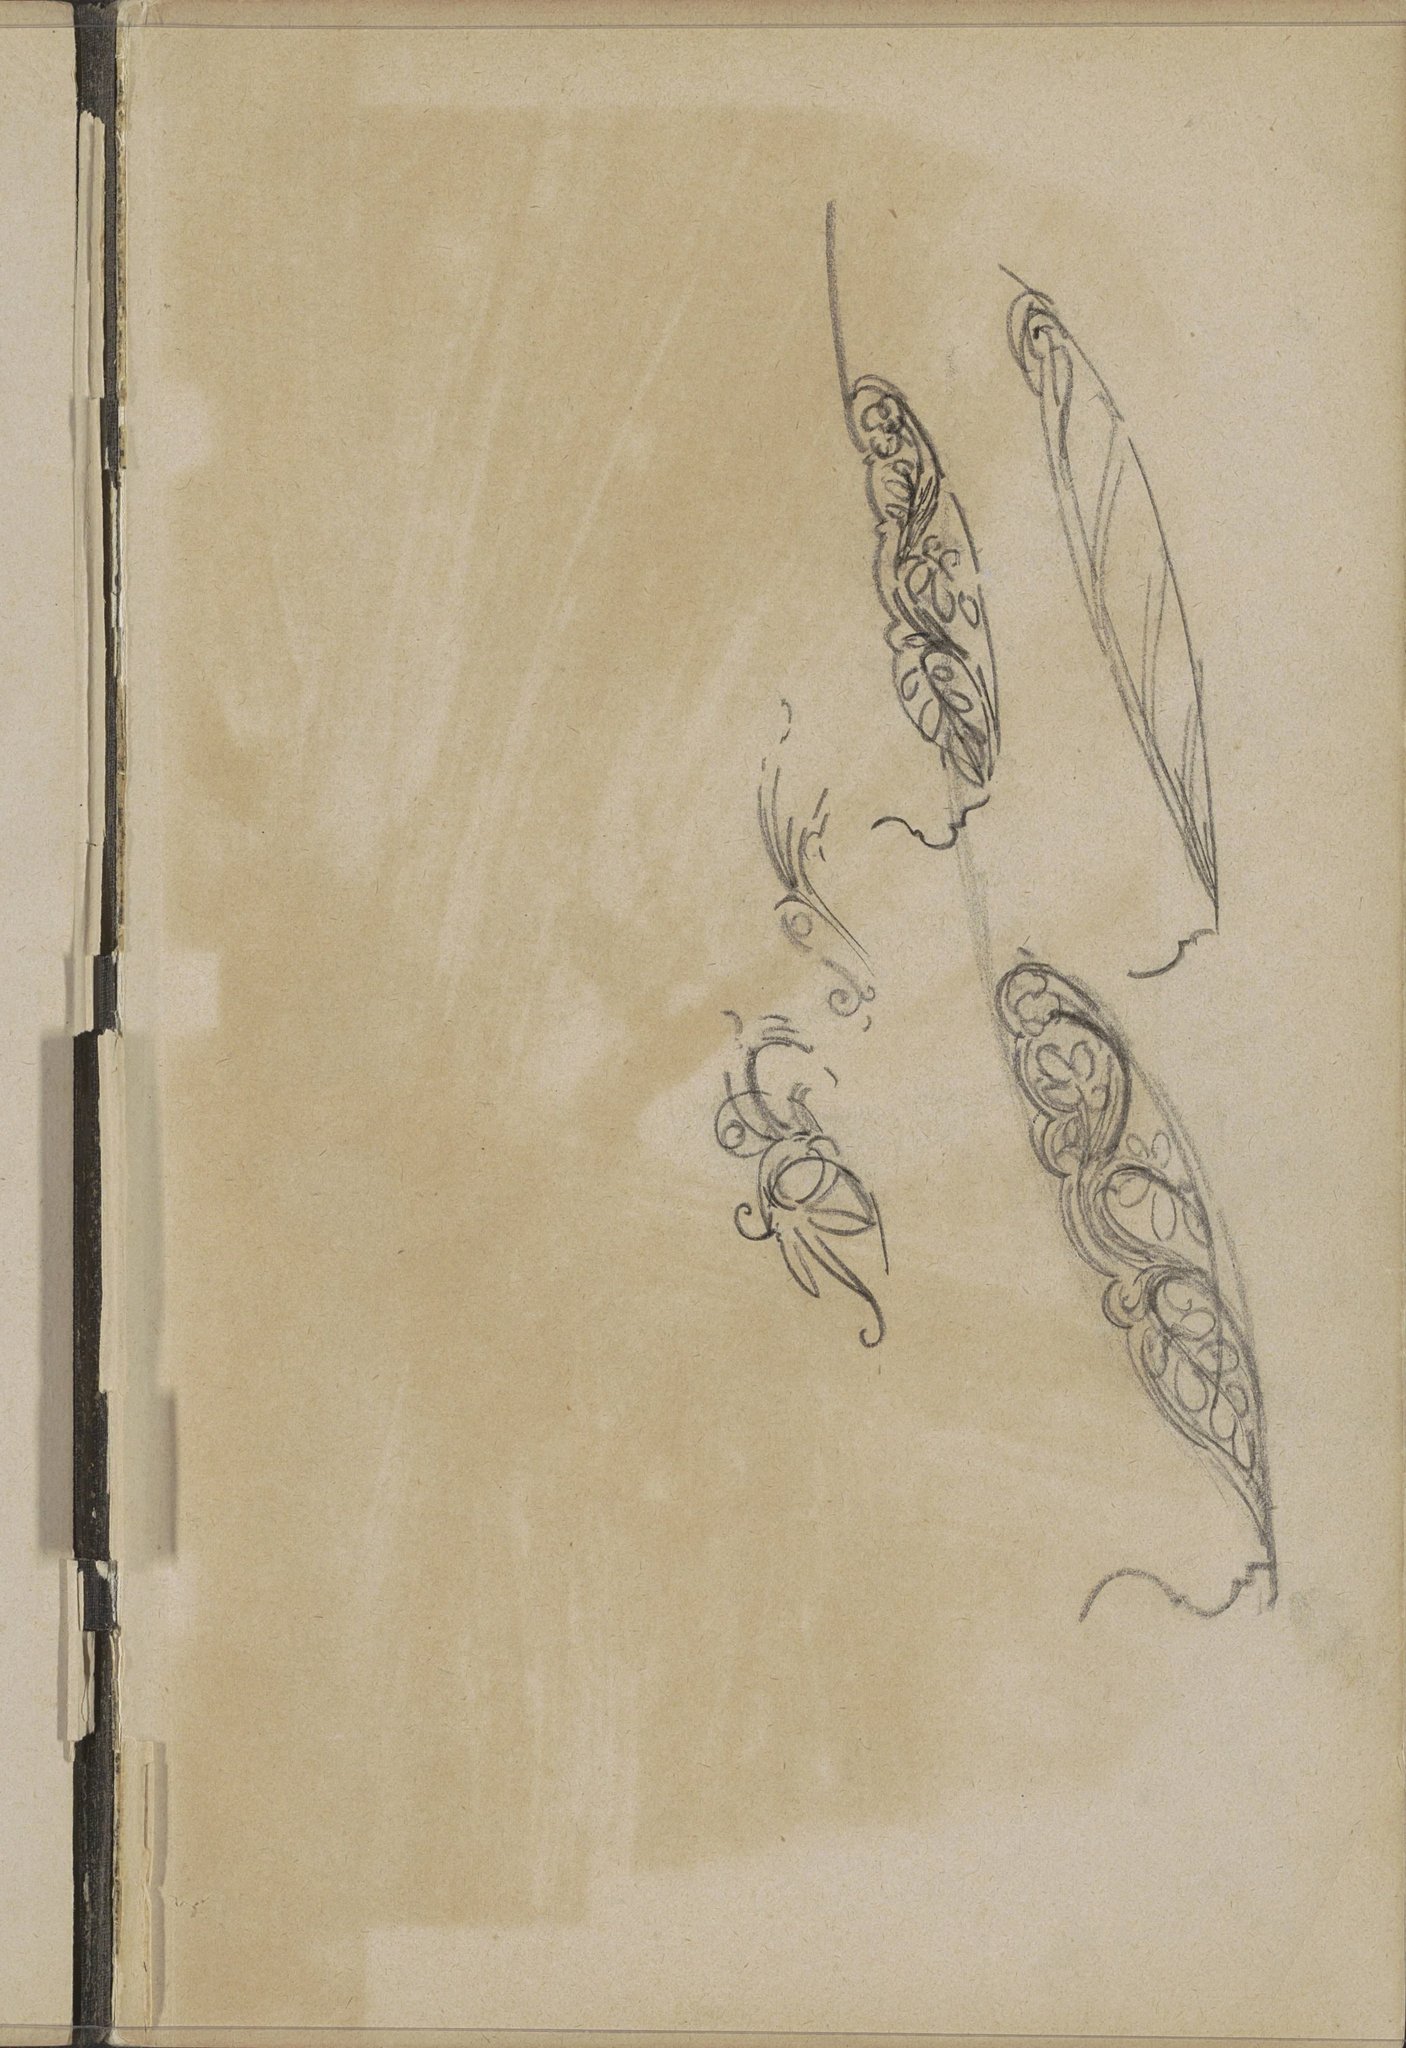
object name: sketchbook leaf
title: Ornamenten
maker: gerrit willem dijsselhof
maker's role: designer, draughtsman, print maker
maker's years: 1866-1924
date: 1901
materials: chalk, paper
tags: flowers ~ ornament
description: Onder andere ornamenten met bloemen. Blad 1 recto uit een schetsboek met 79 bladen.